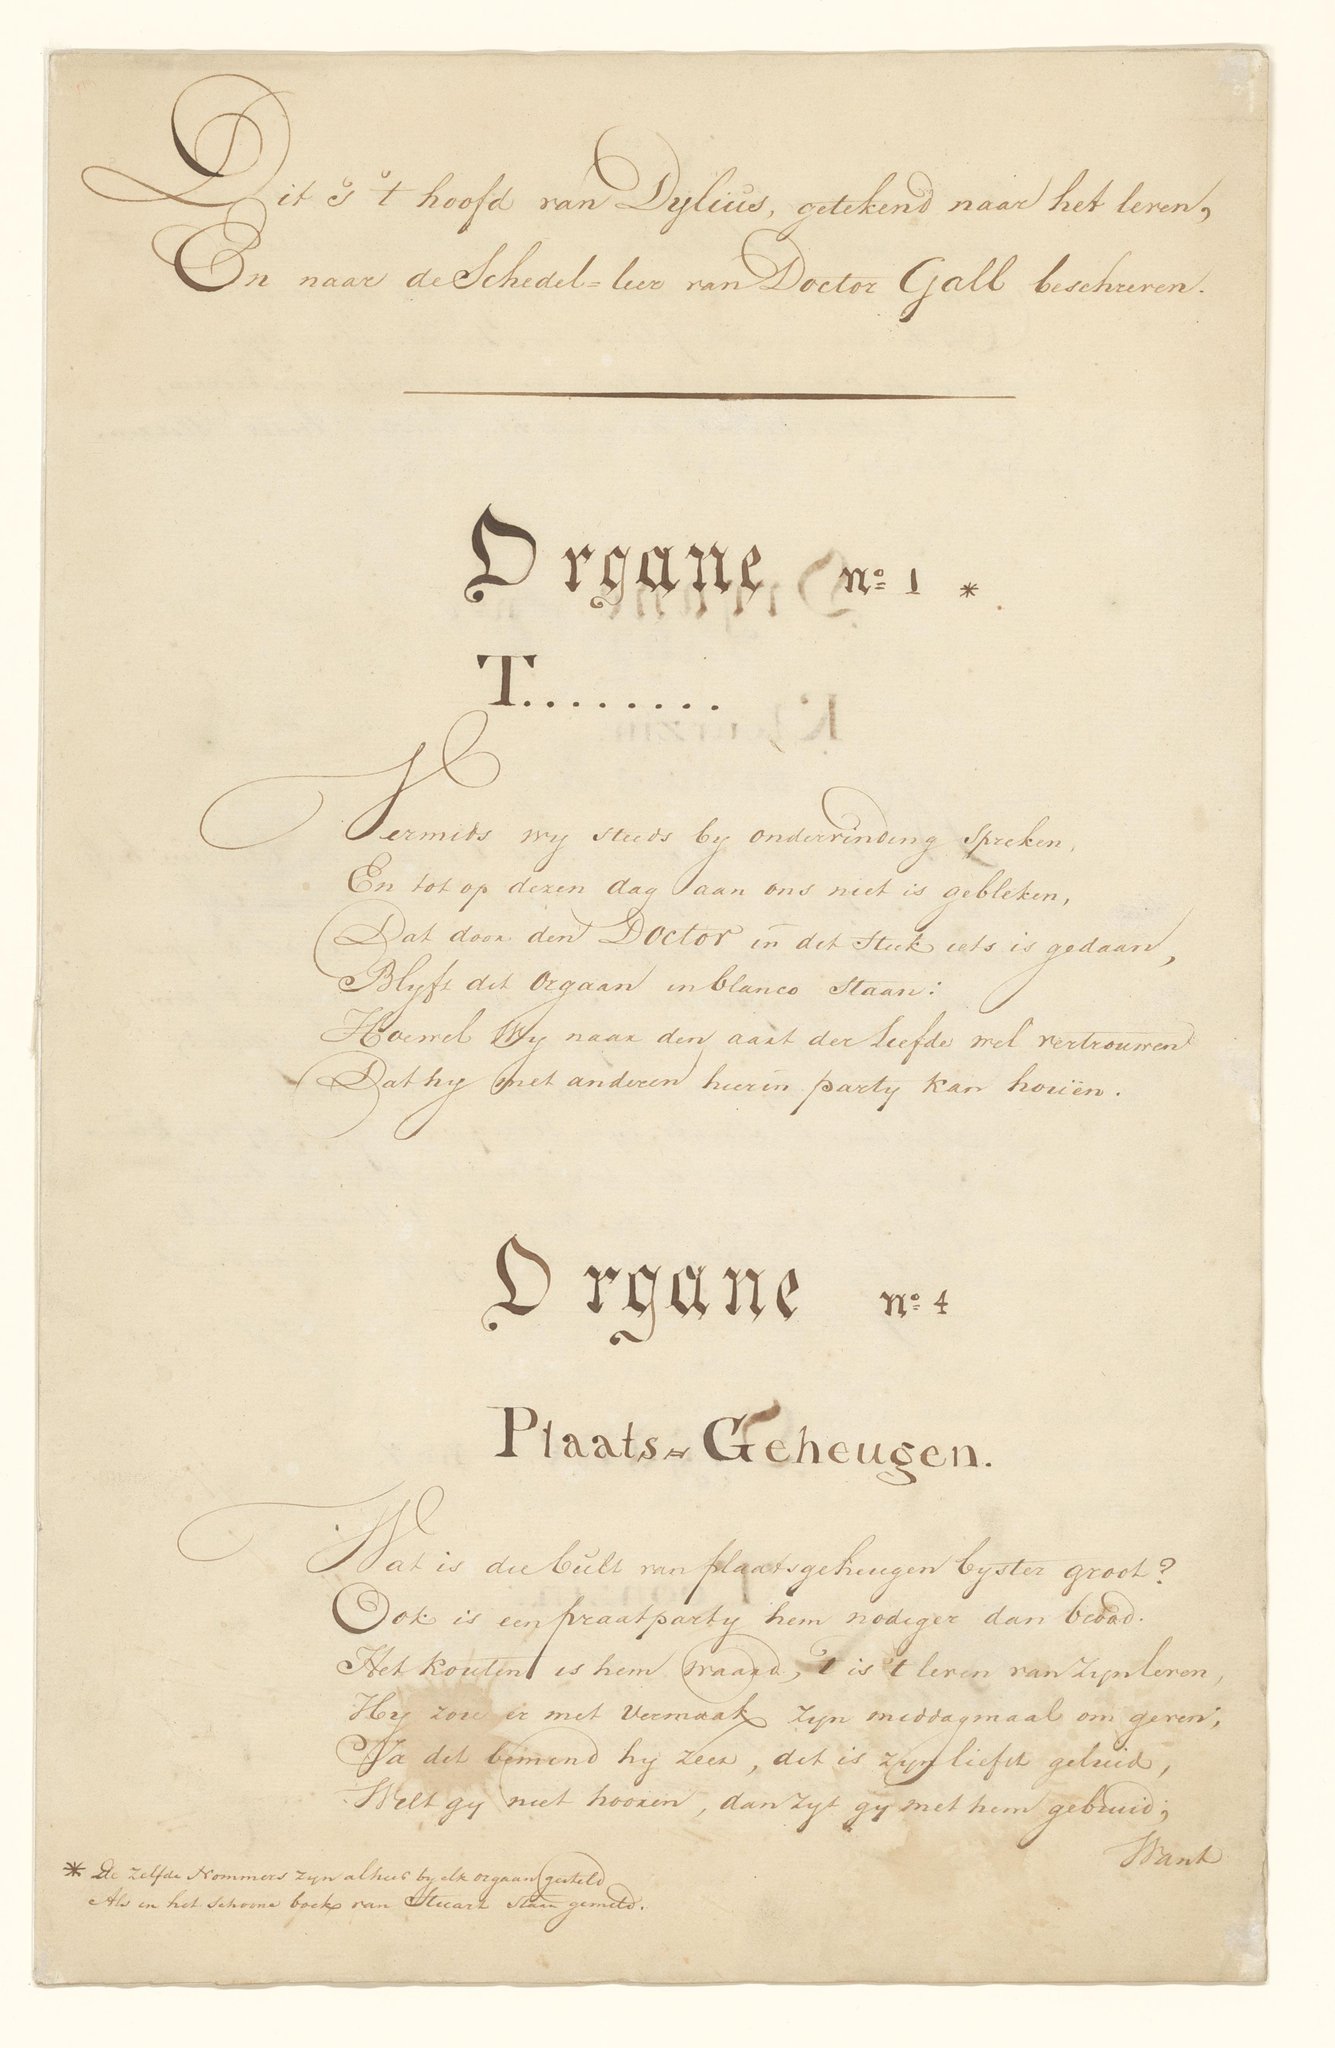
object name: manuscript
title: Dit 's 't hoofd van Dylius, getekend naar het leven, En naar de Schedel-leer van Doctor Gall beschreven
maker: jacob willemz. de vos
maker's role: draughtsman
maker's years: 1774-1844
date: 1806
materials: ink, paper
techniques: pen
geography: netherlands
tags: amsterdam, utrecht, phrenology, head (human), (human) skull, physician, doctor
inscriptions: collector's mark: Lugt 1641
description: Handschrift met beschrijvingen op rijm met verklaringen van de genummerde knobbels op de schedel zoals getekend op het portret van Daniel Dijlius (zie KOG-ZG-4-5-1). Volgens de leer van Gall duiden die de plaats aan van verschillende hersenfuncties. In deze tekst zijn dat: T(eeltdrift), Plaats Geheugen, Kleurzin, Toonzin, Kunstzin, Moordzin, Geestigheid, Boven natuurkundige Diepzinnigheid, Goedaardigheid en Vriendschappelijke Gehegtheid. Waarschijnlijk gemaakt ter gelegenheid van een feestmaaltijd met vrienden aangeboden door Dijlius. Geschreven op twee dubbelgevouwen aan elkaar genaaide bladen.